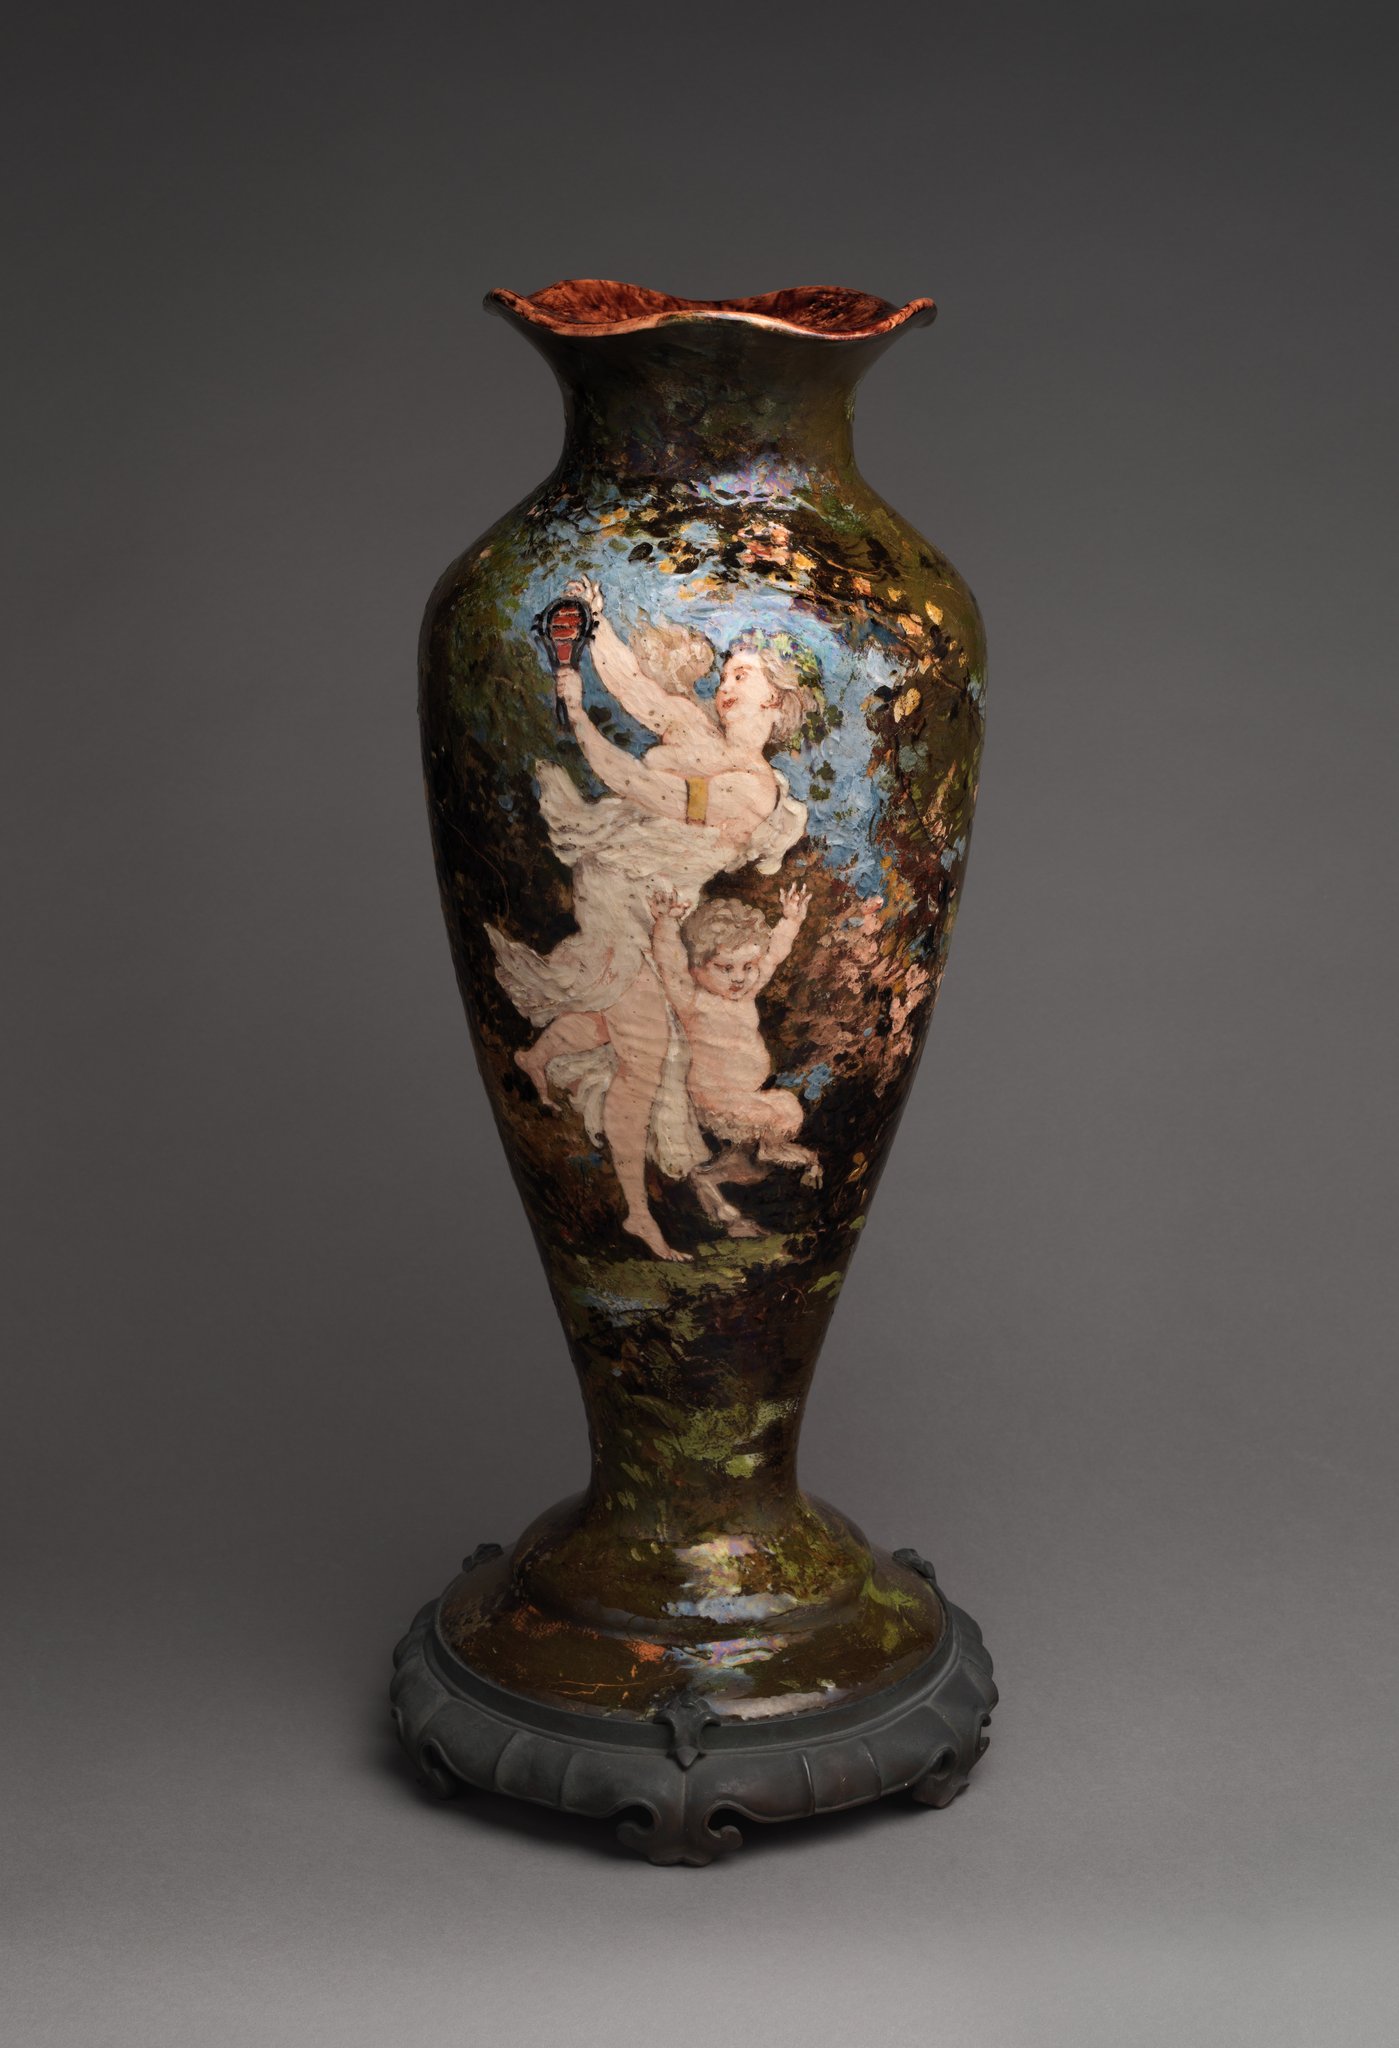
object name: vase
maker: haviland & co.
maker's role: factory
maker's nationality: american and french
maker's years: 1864-1931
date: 1801-1900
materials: pottery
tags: women,fauns